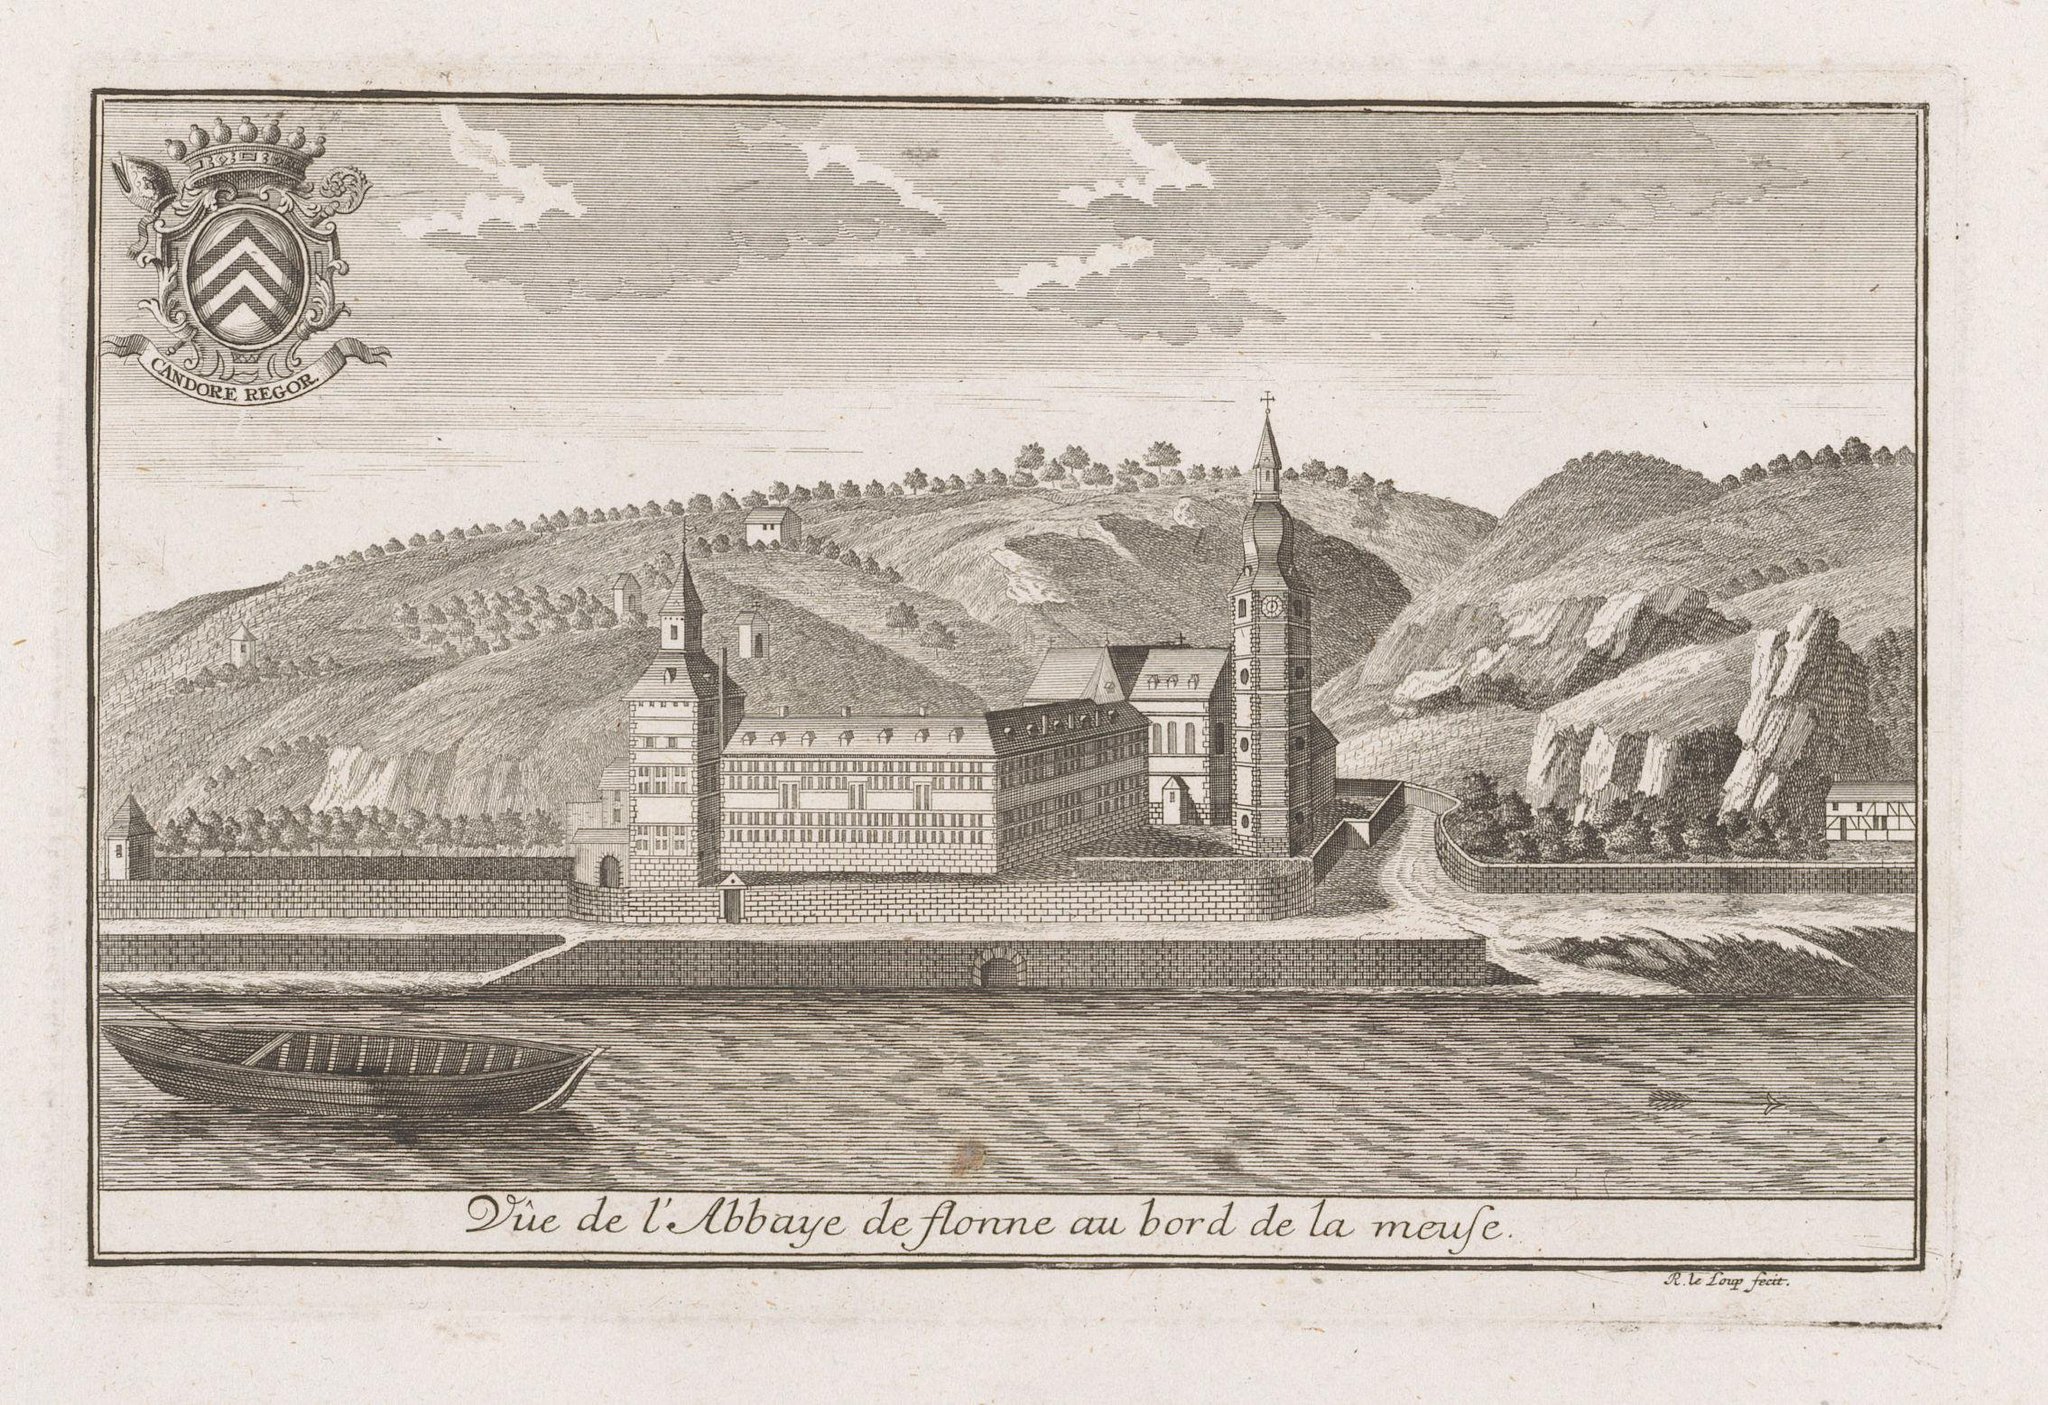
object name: book illustration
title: Vûe du l'Abbaye de Flonne au bord de la Meuse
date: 1738-1744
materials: paper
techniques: engraving, etching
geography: liège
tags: abbey, monastery, convent ~ roman catholic church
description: Prent uit: Johanne de Saumery, Alexandre de et al. Les délices du païs de Liège, ou description géographique, topographique et chorographique des monumes sacrés et profanes (...). 5 dln. Luik: Everard Kints, 1738-1744, dl. 1, p. 363.